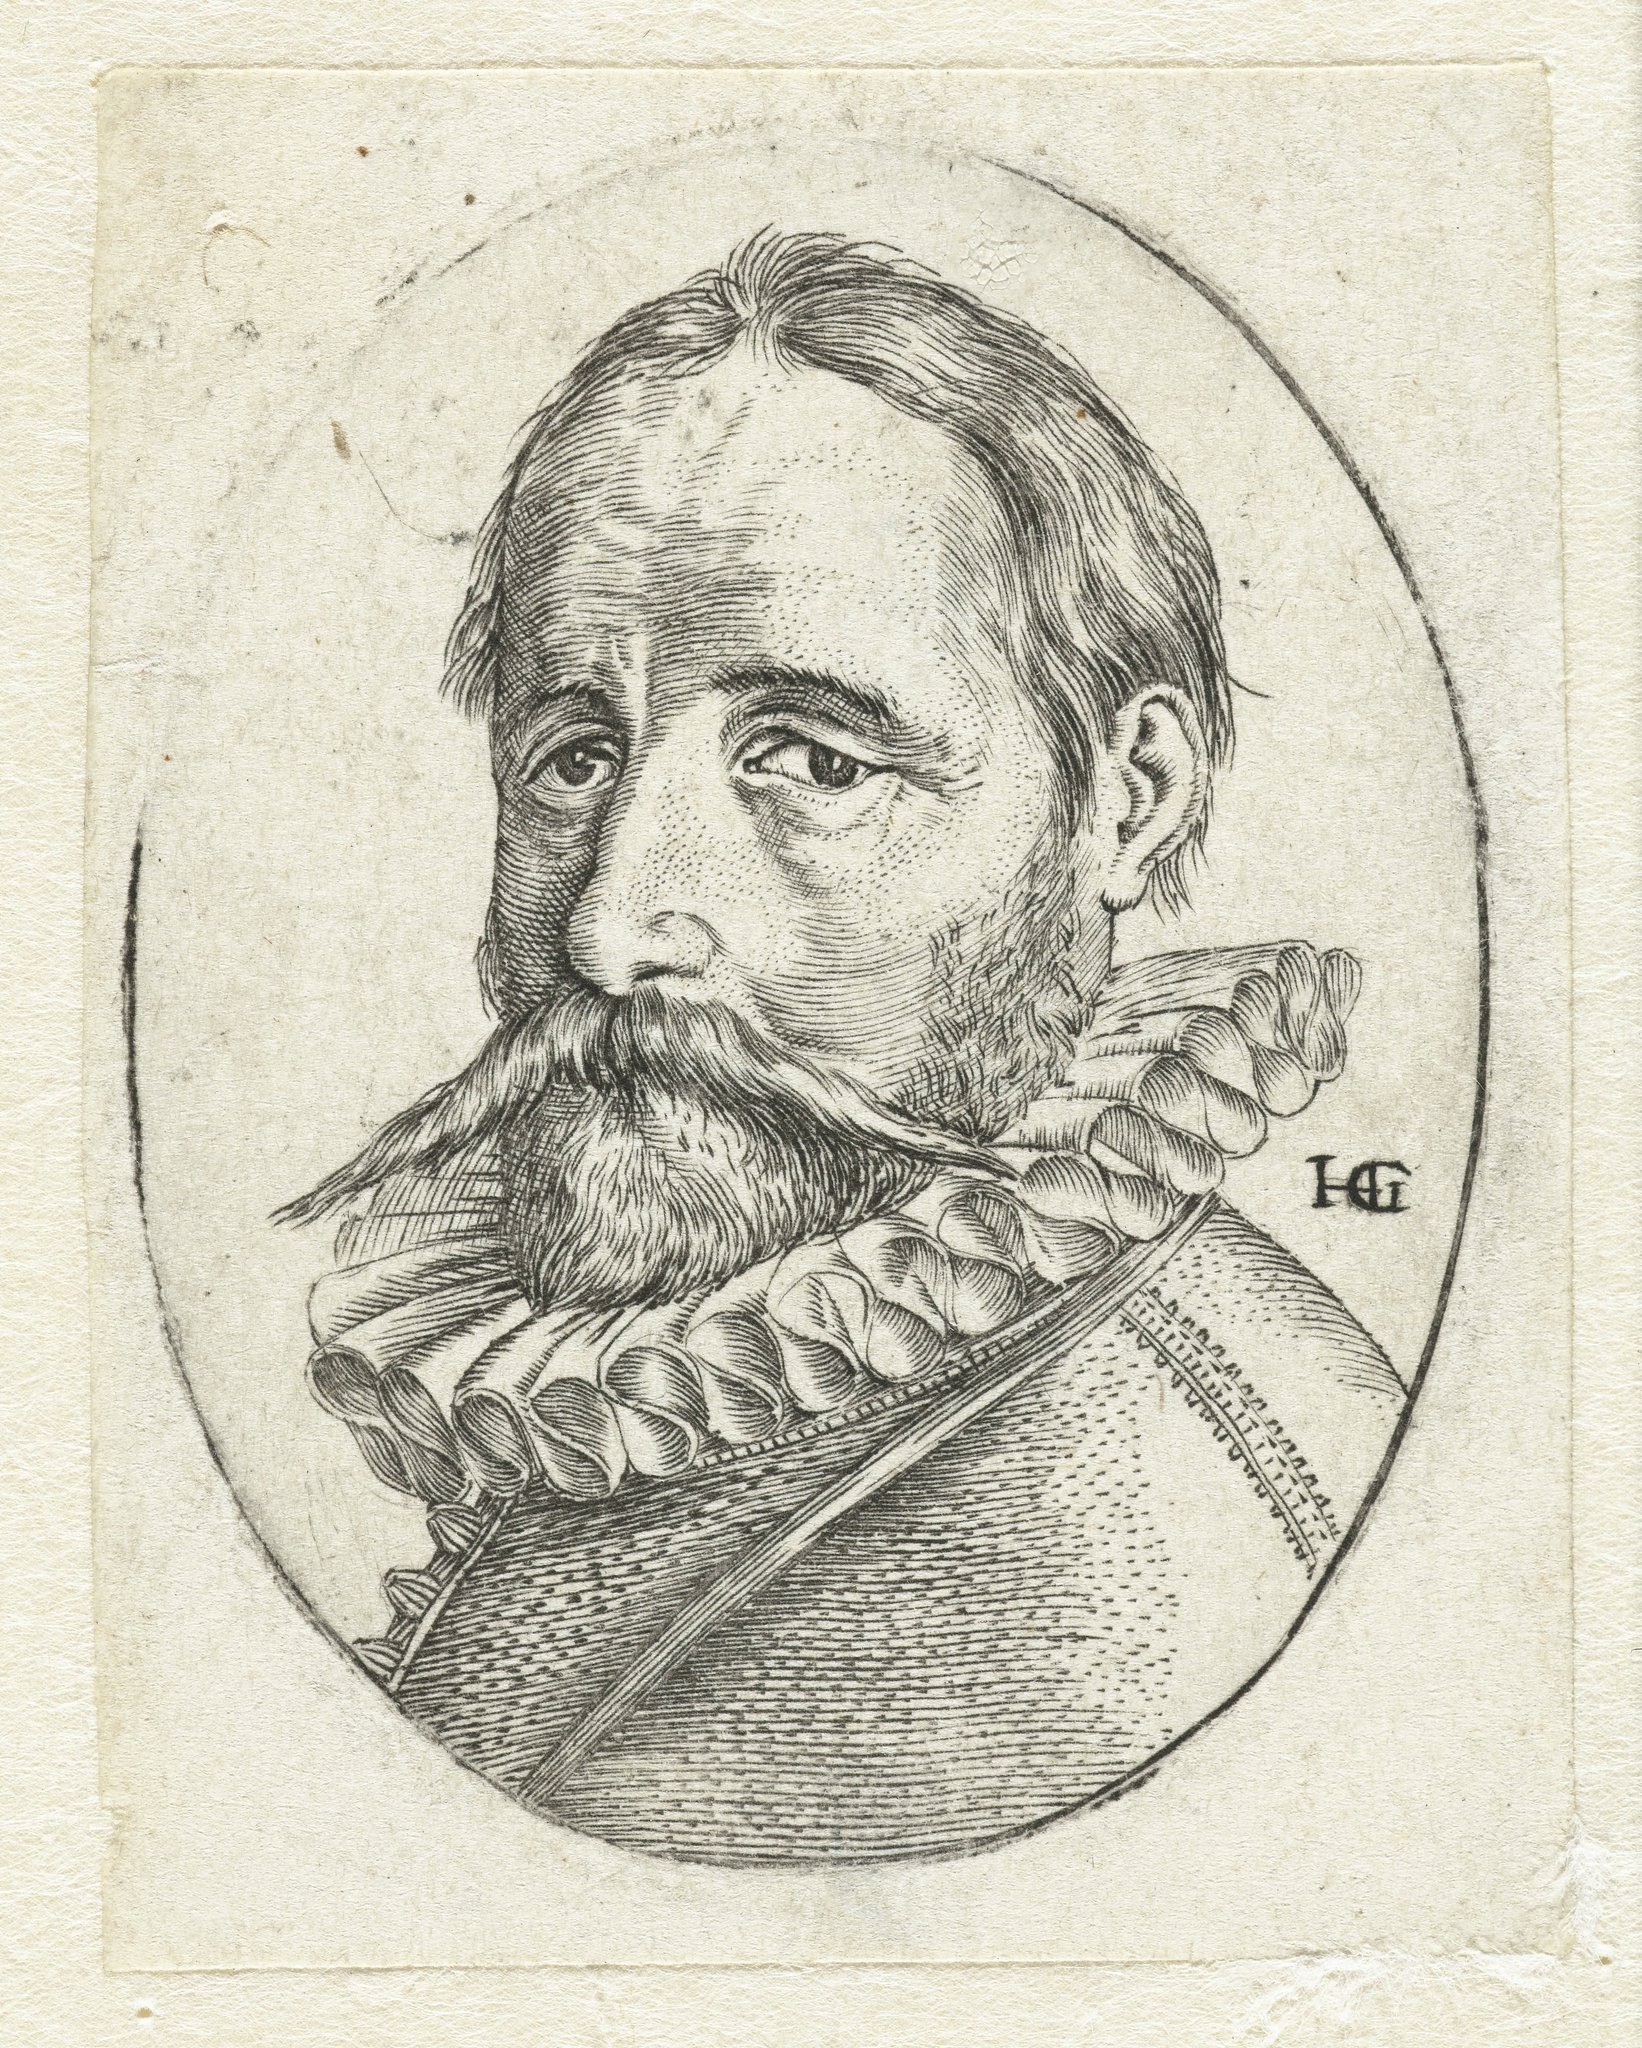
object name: print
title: Portret Hans Bol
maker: Anonymous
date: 1593-1600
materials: paper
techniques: engraving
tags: portrait, self-portrait of painter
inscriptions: monogram: ‘HG’, mark: ‘twee keer L.2760’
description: Portretbuste Hans Bol (1534-1593). Hoofd gedraaid naar links, blik gericht naar de beschouwer.